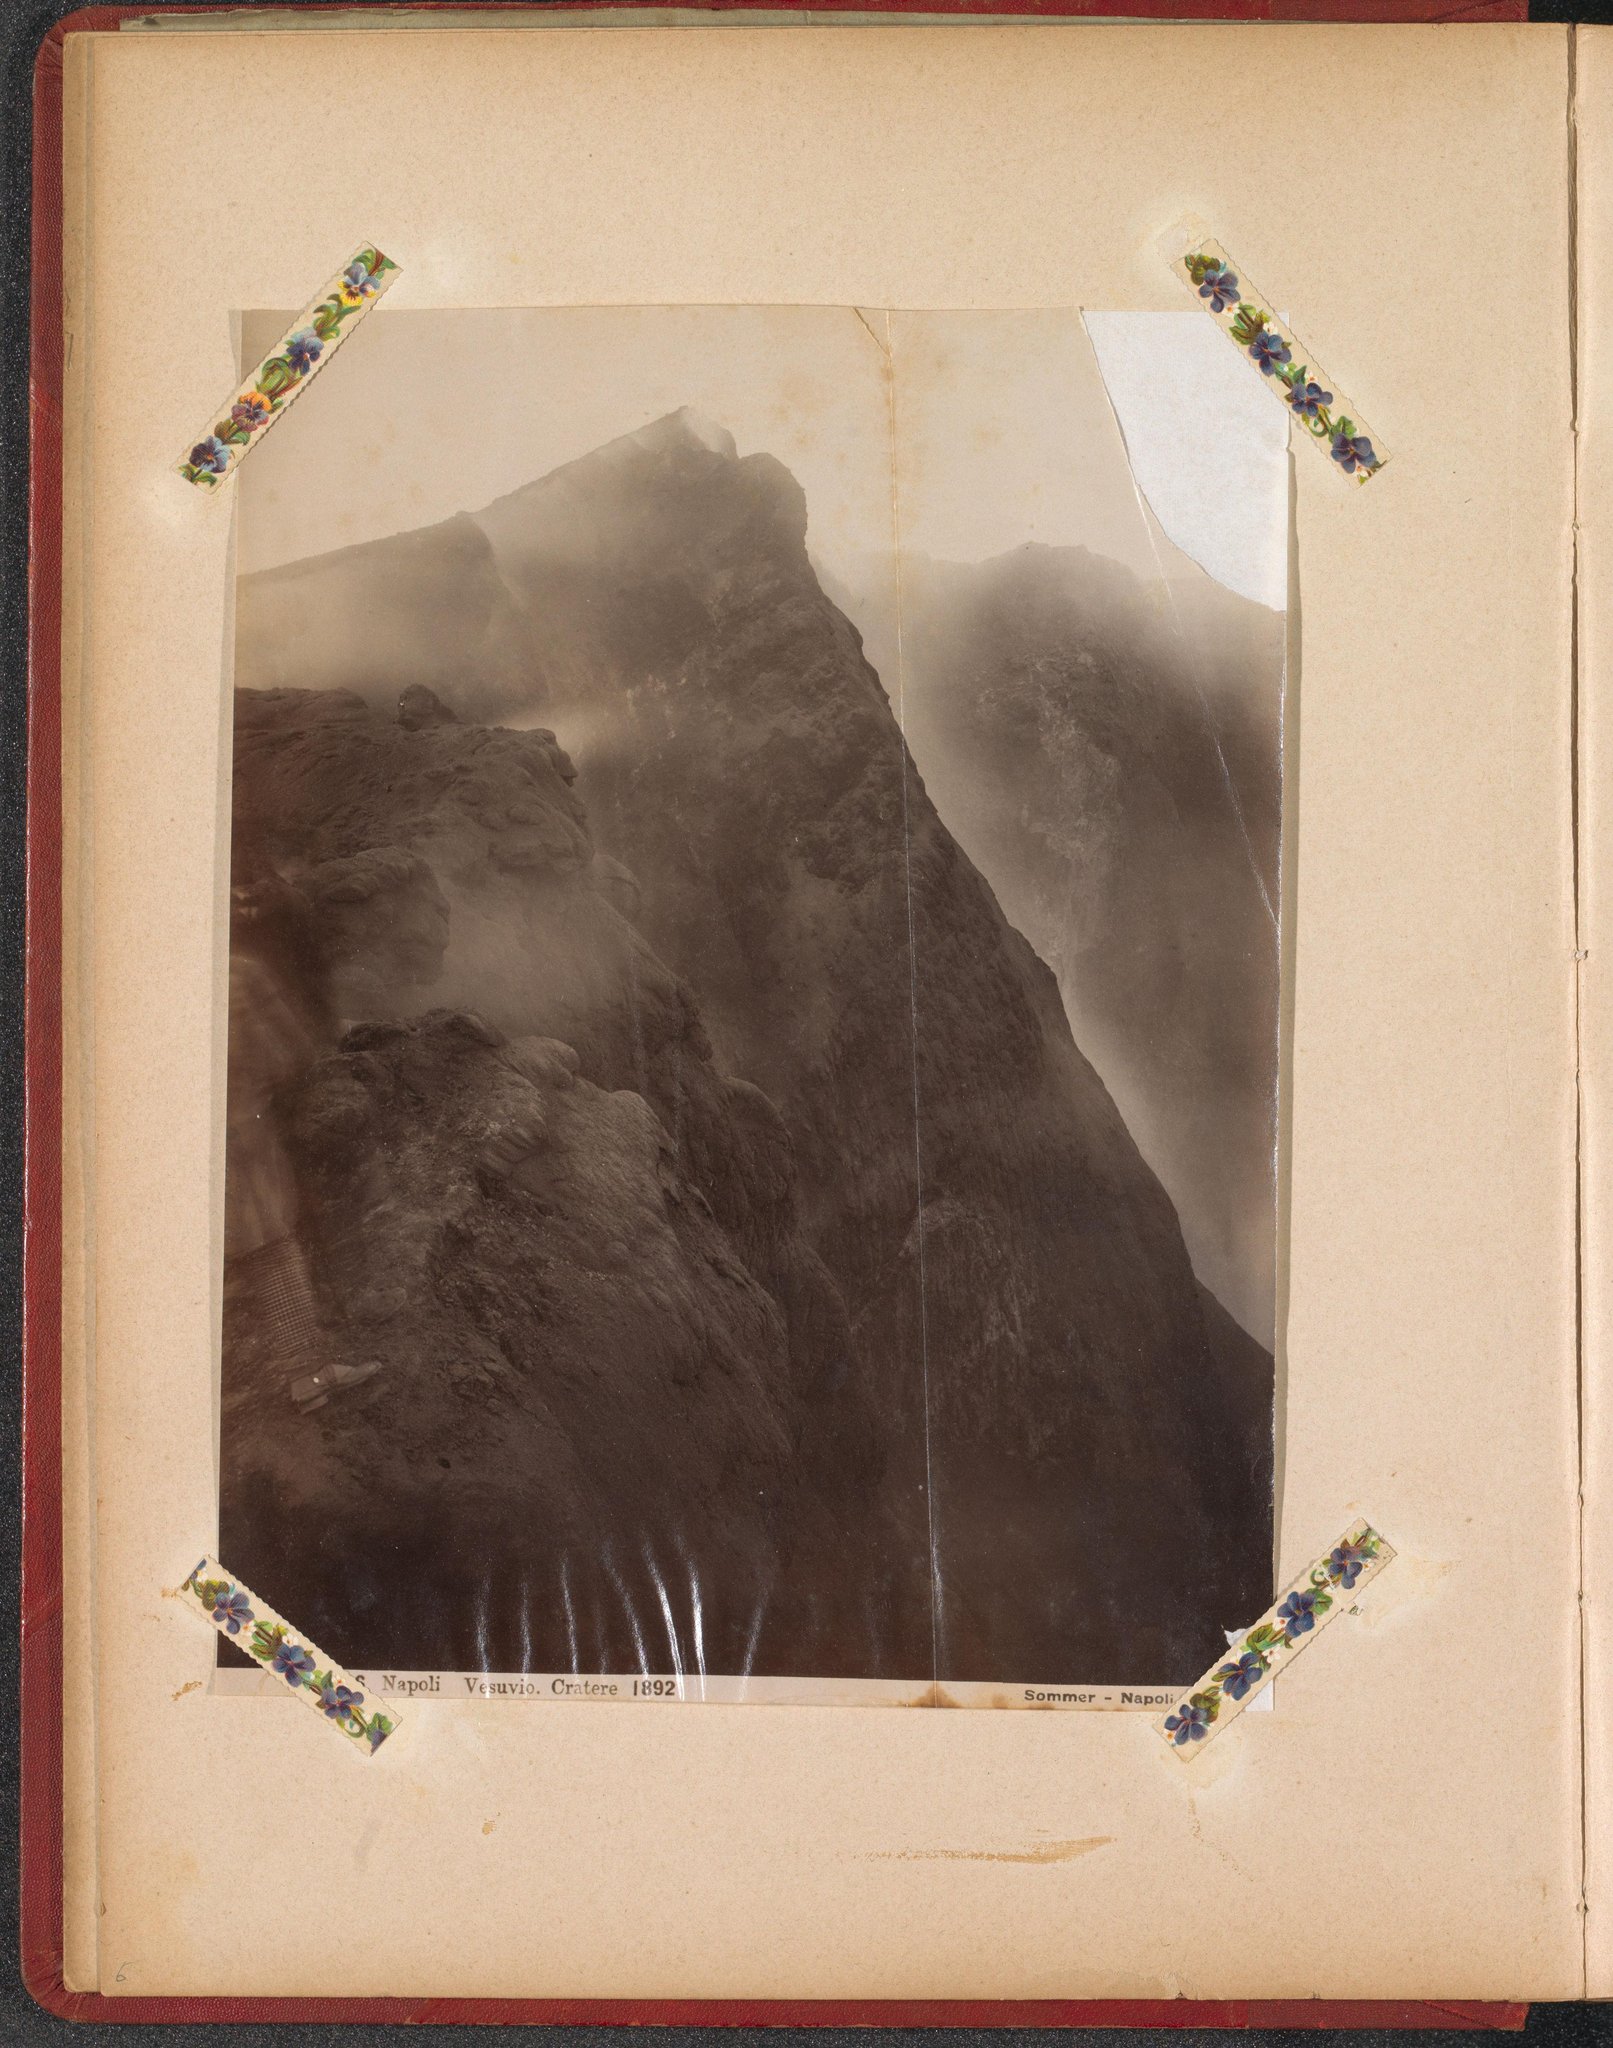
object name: album leaf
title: Napoli. Vesuvio. Cratere 1892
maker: giorgio sommer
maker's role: fotograaf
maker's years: 1834-1914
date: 1870-1900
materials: paper, photographic support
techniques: albumen print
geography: mount vesuvius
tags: volcano, mount vesuvius, naples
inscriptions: negative number: ‘2536’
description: Onderdeel van Reisalbum met foto's van bezienswaardigheden in Italië en Zuid-Frankrijk.